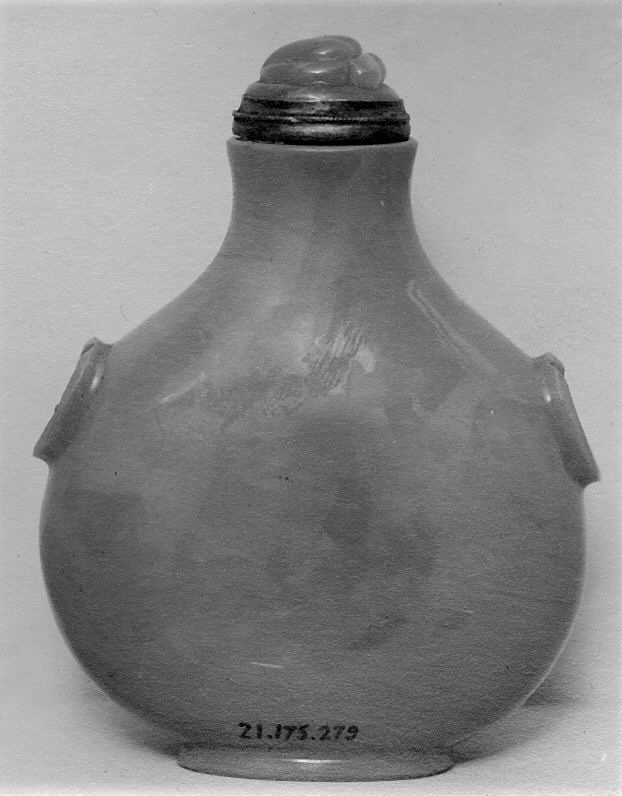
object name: snuff bottle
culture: chinese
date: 1767-1800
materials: glass, jade